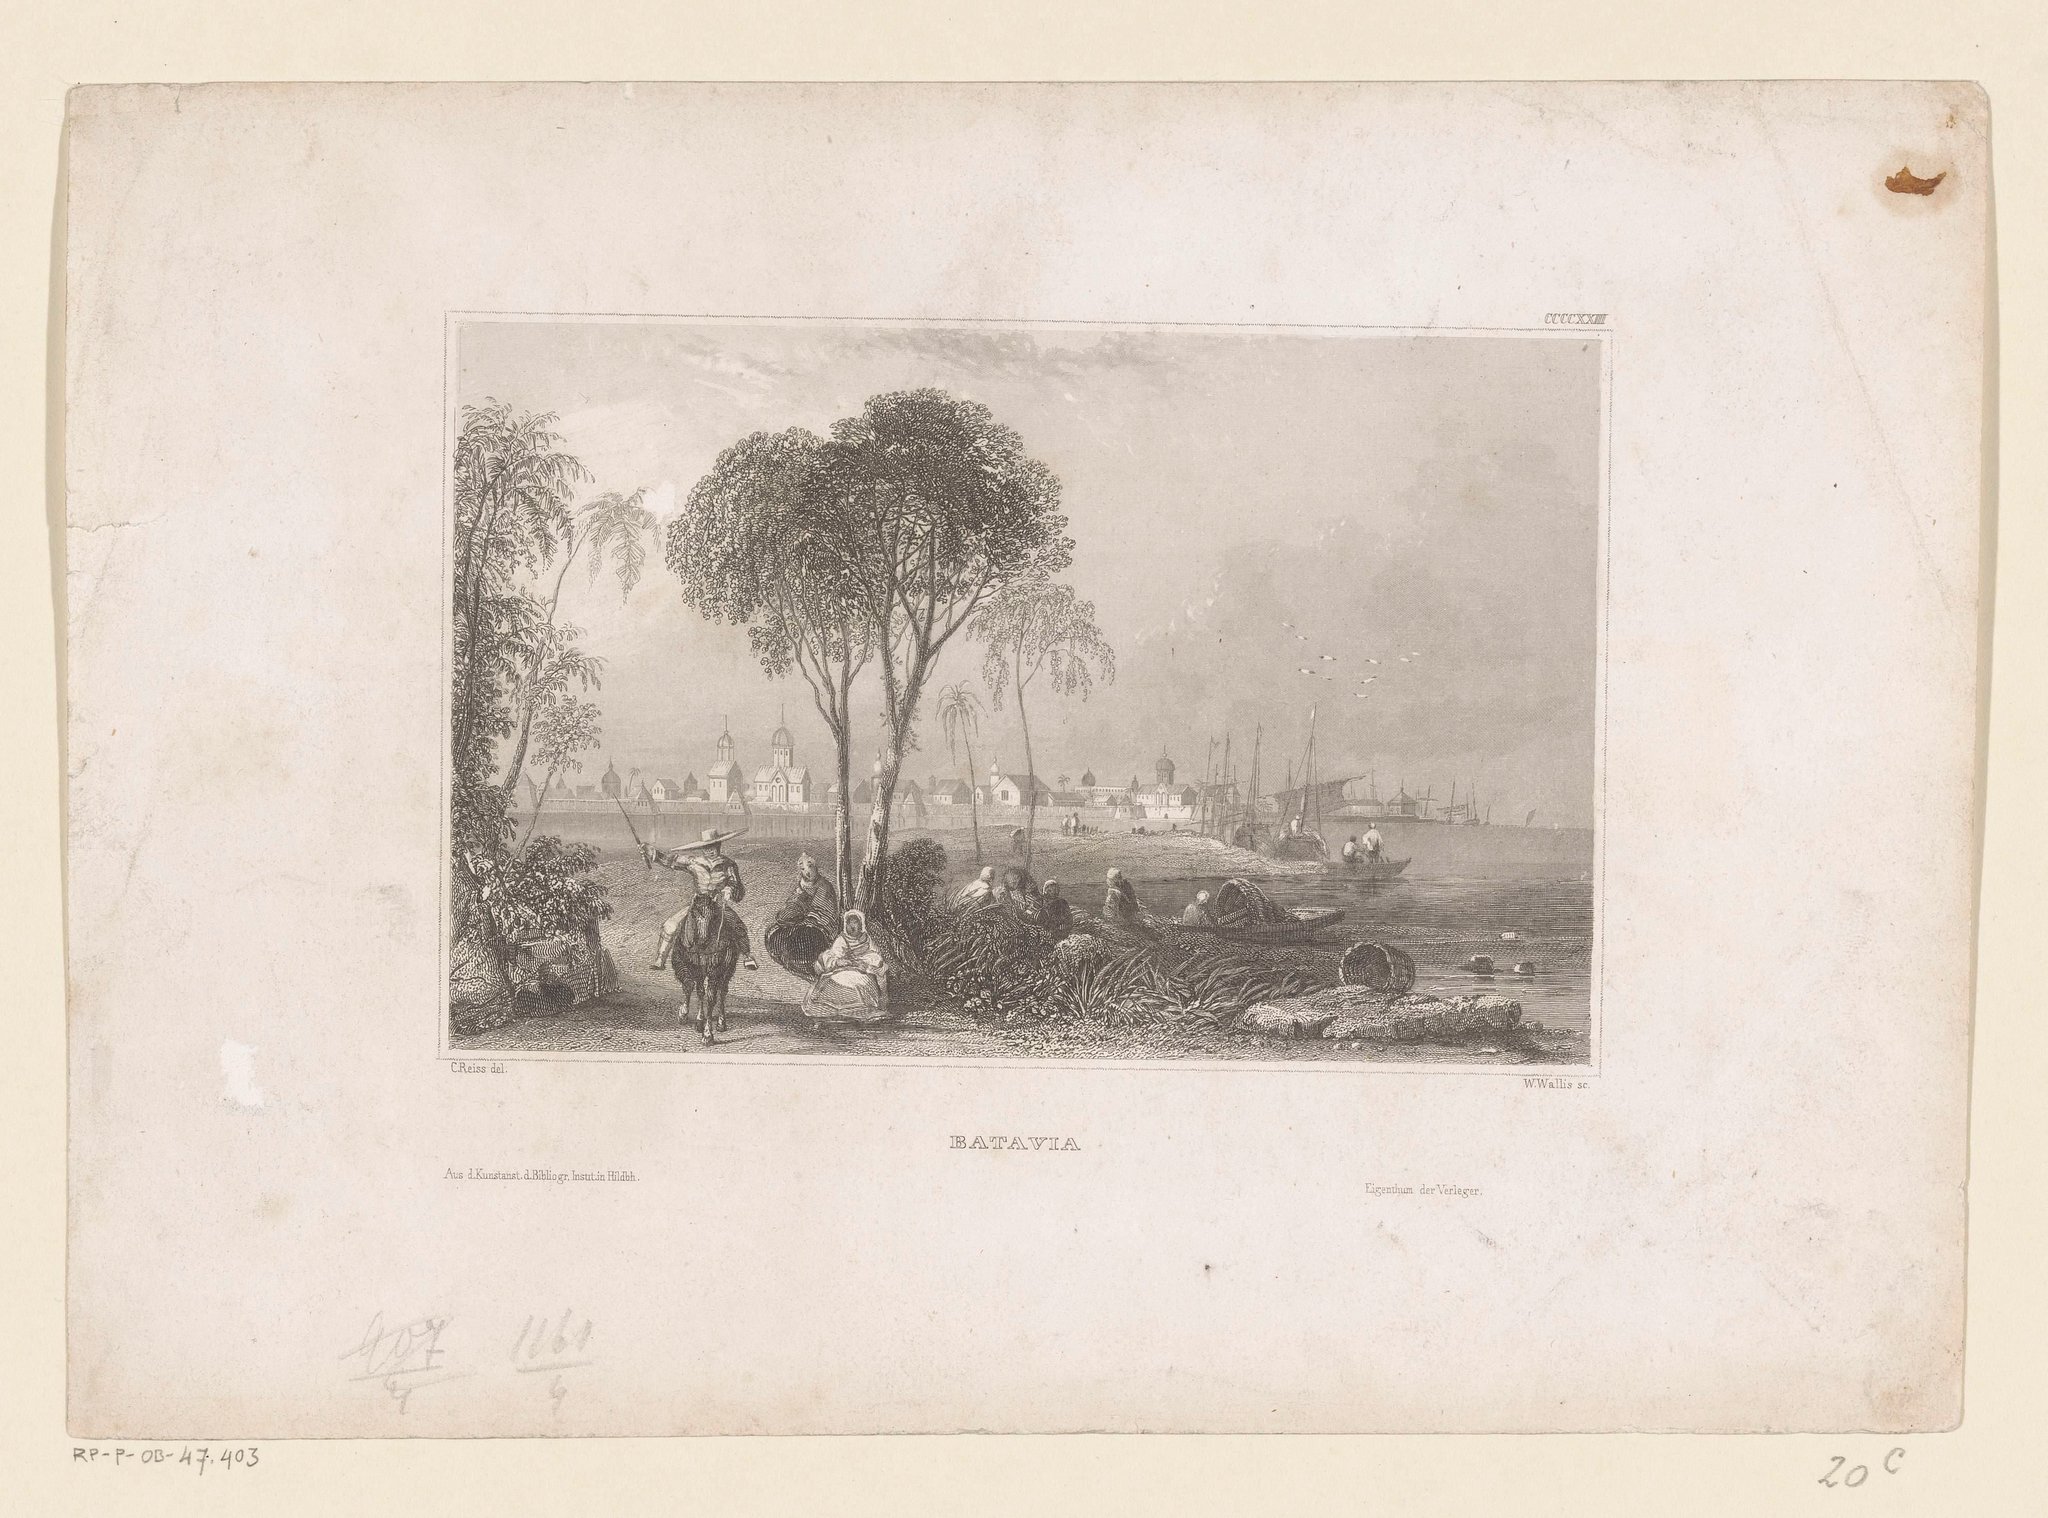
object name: print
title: Batavia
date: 1828-1874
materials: paper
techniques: engraving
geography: germany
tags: drawbridge ~ fortified city, bascule bridge, batavia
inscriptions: stamp: ‘Doublet’